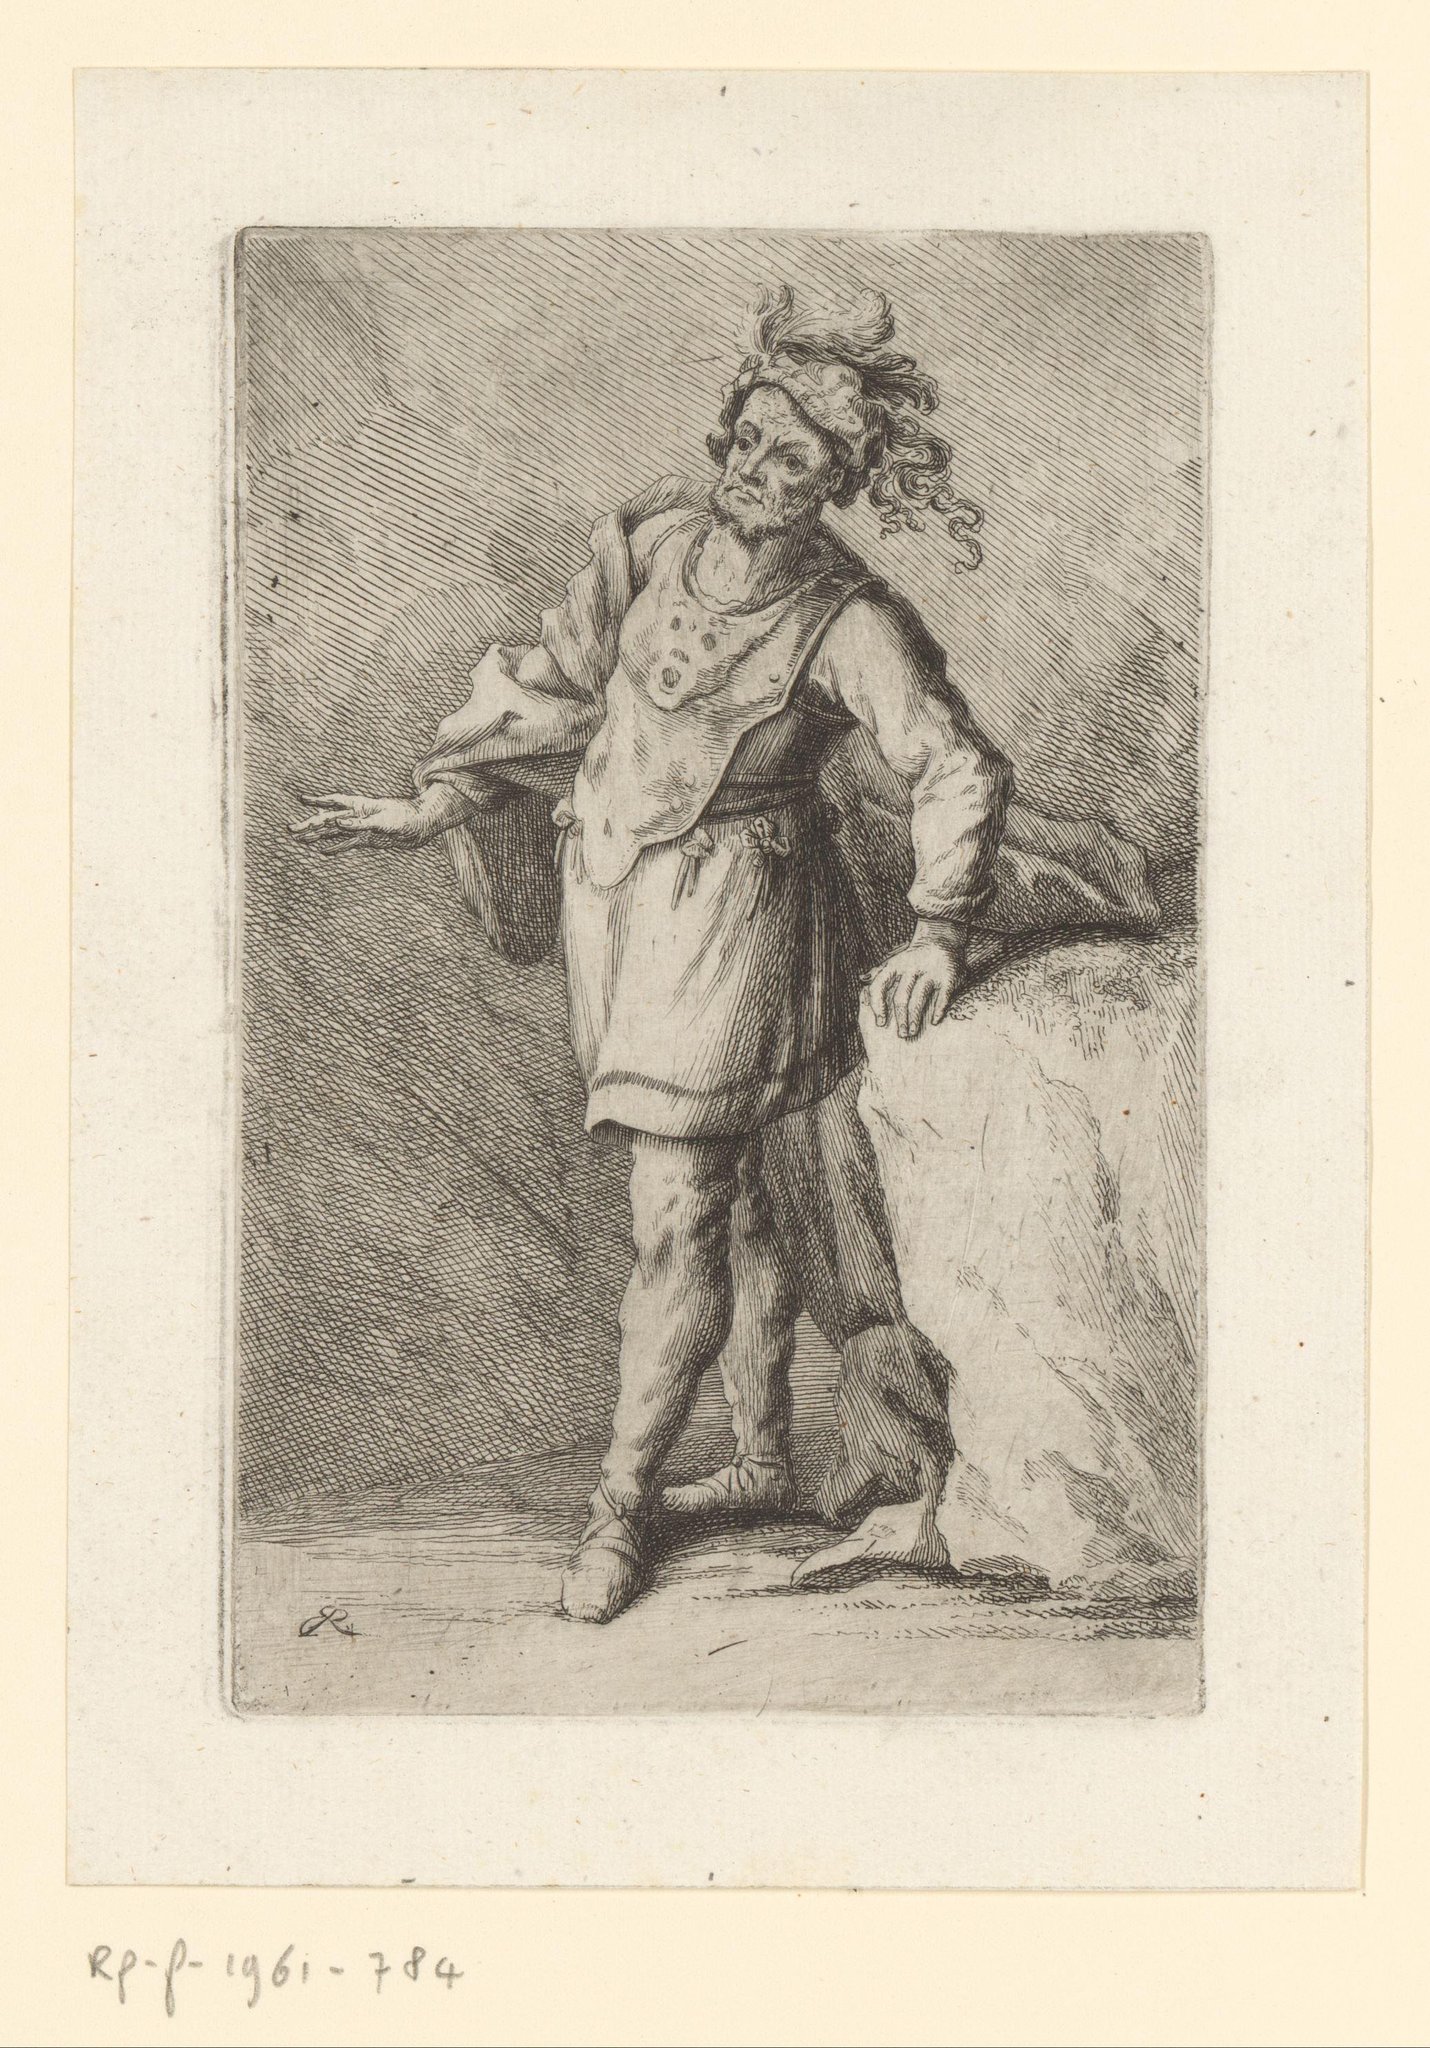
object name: print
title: Staande krijgsman met gevederde baret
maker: johann elias ridinger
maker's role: draughtsman, painter, print maker, publisher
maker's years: 1698-1767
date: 1728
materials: paper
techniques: etching, intaglio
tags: the soldier; the soldier's life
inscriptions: collector's mark: Lugt 2228